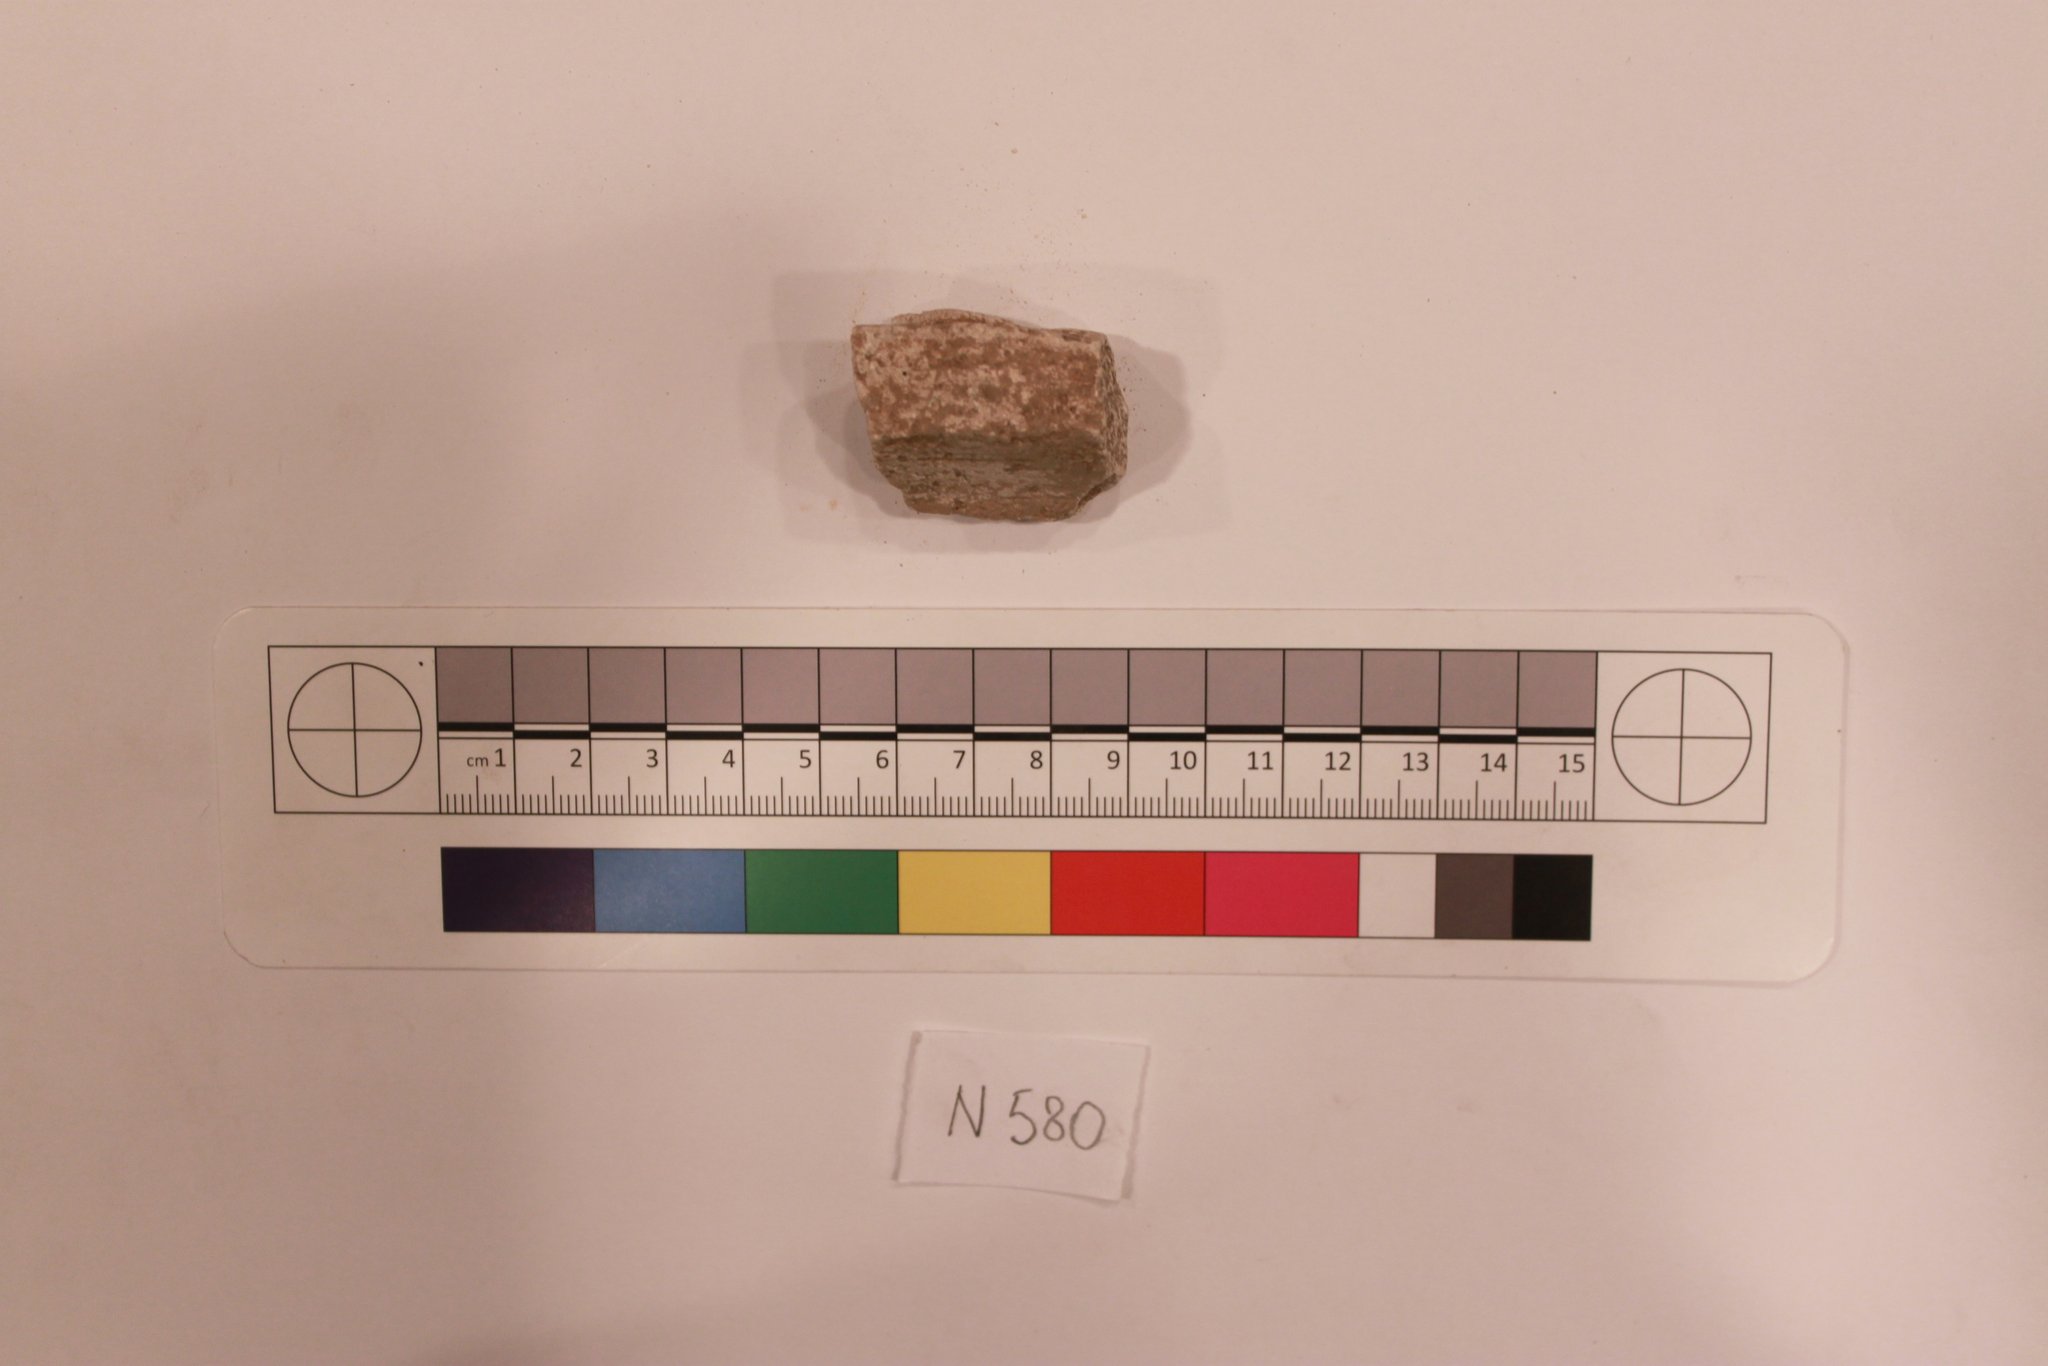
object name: fragment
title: Stucco Fragment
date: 701-1200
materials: plaster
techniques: carving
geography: iran